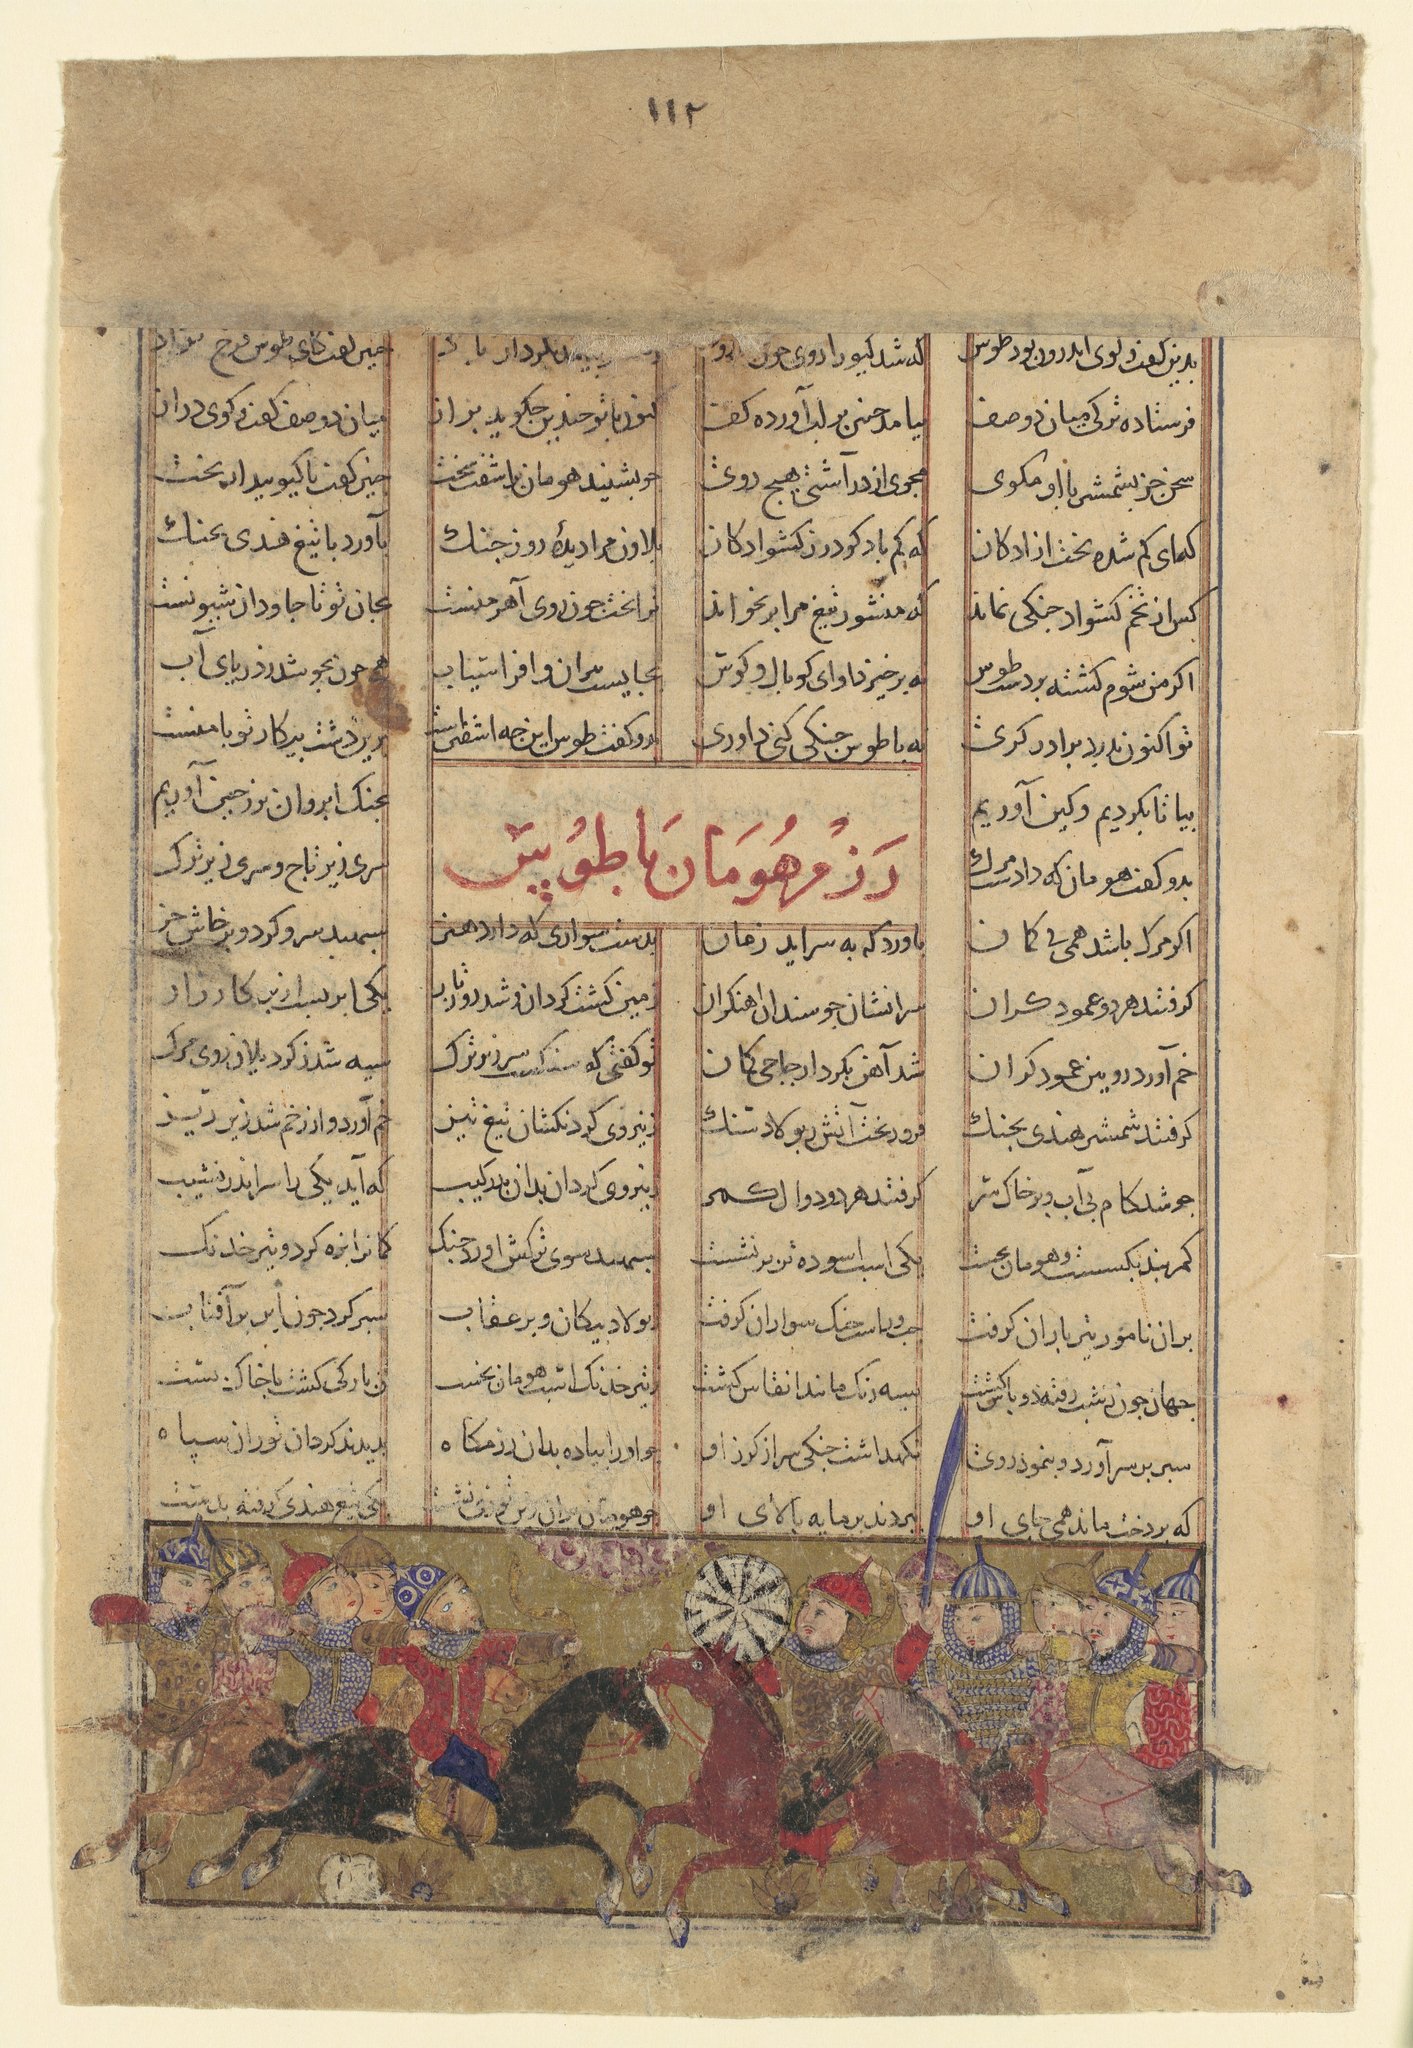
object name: folio from an illustrated manuscript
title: "The Combat of Tus and Human," Folio from a Shahnama (Book of Kings)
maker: abu'l qasim firdausi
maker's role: author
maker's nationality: iranian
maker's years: 935-1020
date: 1330-1340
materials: gold, ink, paper, silver, watercolor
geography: iran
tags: battles,soldiers,horses